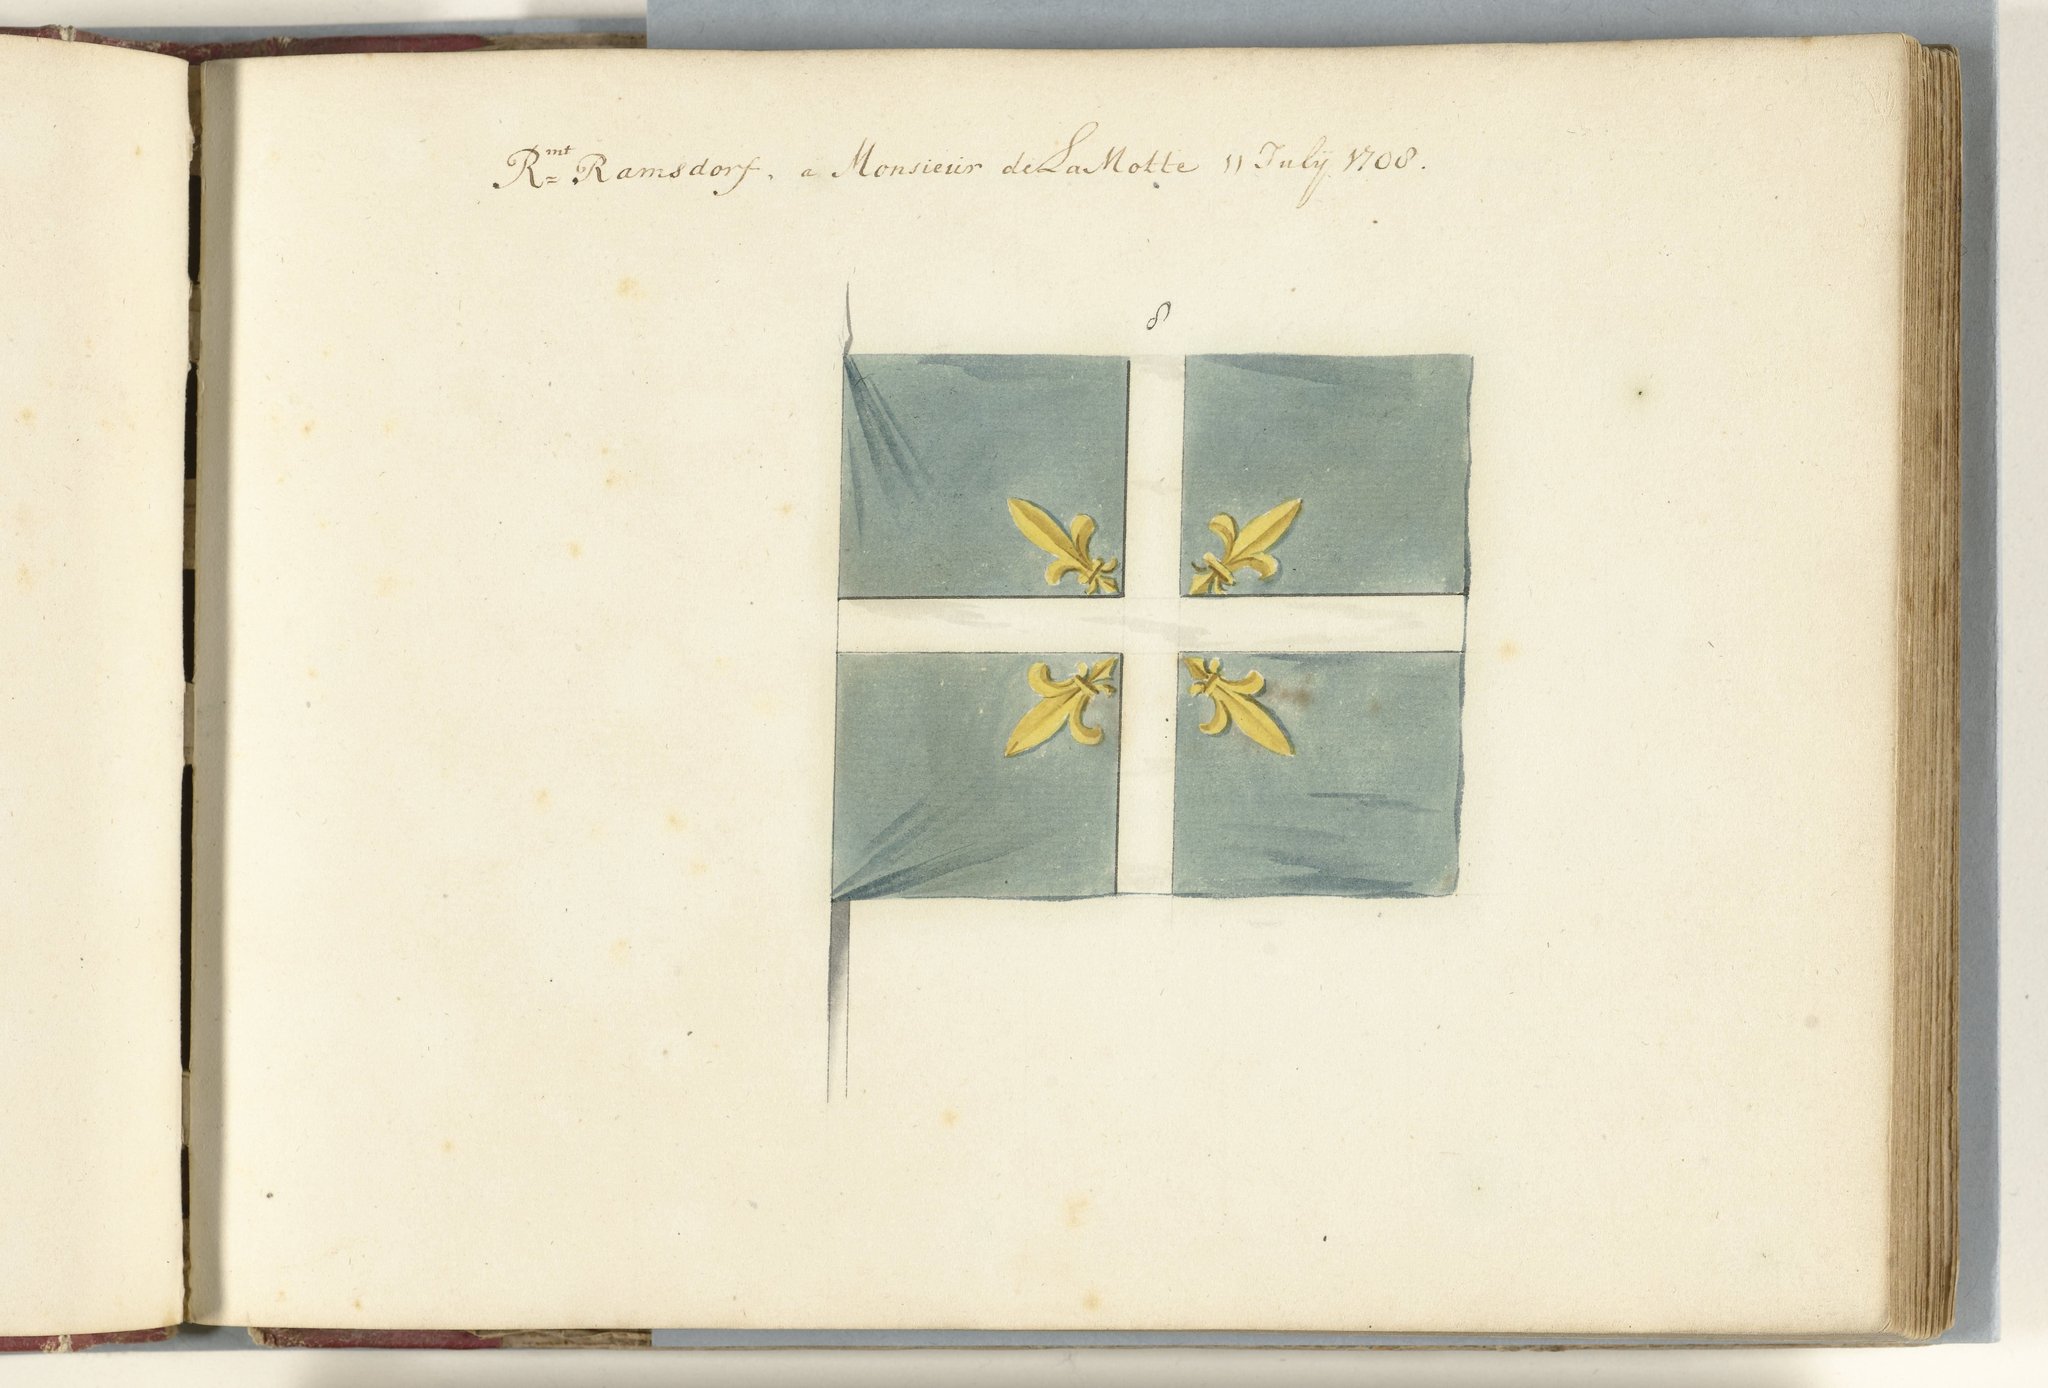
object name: drawing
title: Frans vaandel veroverd in de slag bij Oudenaarde, 1708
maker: Anonymous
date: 1713-1720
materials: paper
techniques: drawing, writing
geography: northern netherlands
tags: (military) flags and standards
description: Frans vaandel veroverd bij de slag bij Oudenaarde in 1708. In het boek met tekeningen van Franse vaandels, standaarden en pauken, veroverd tijdens de Spaanse Successieoorlog (1701-1713).